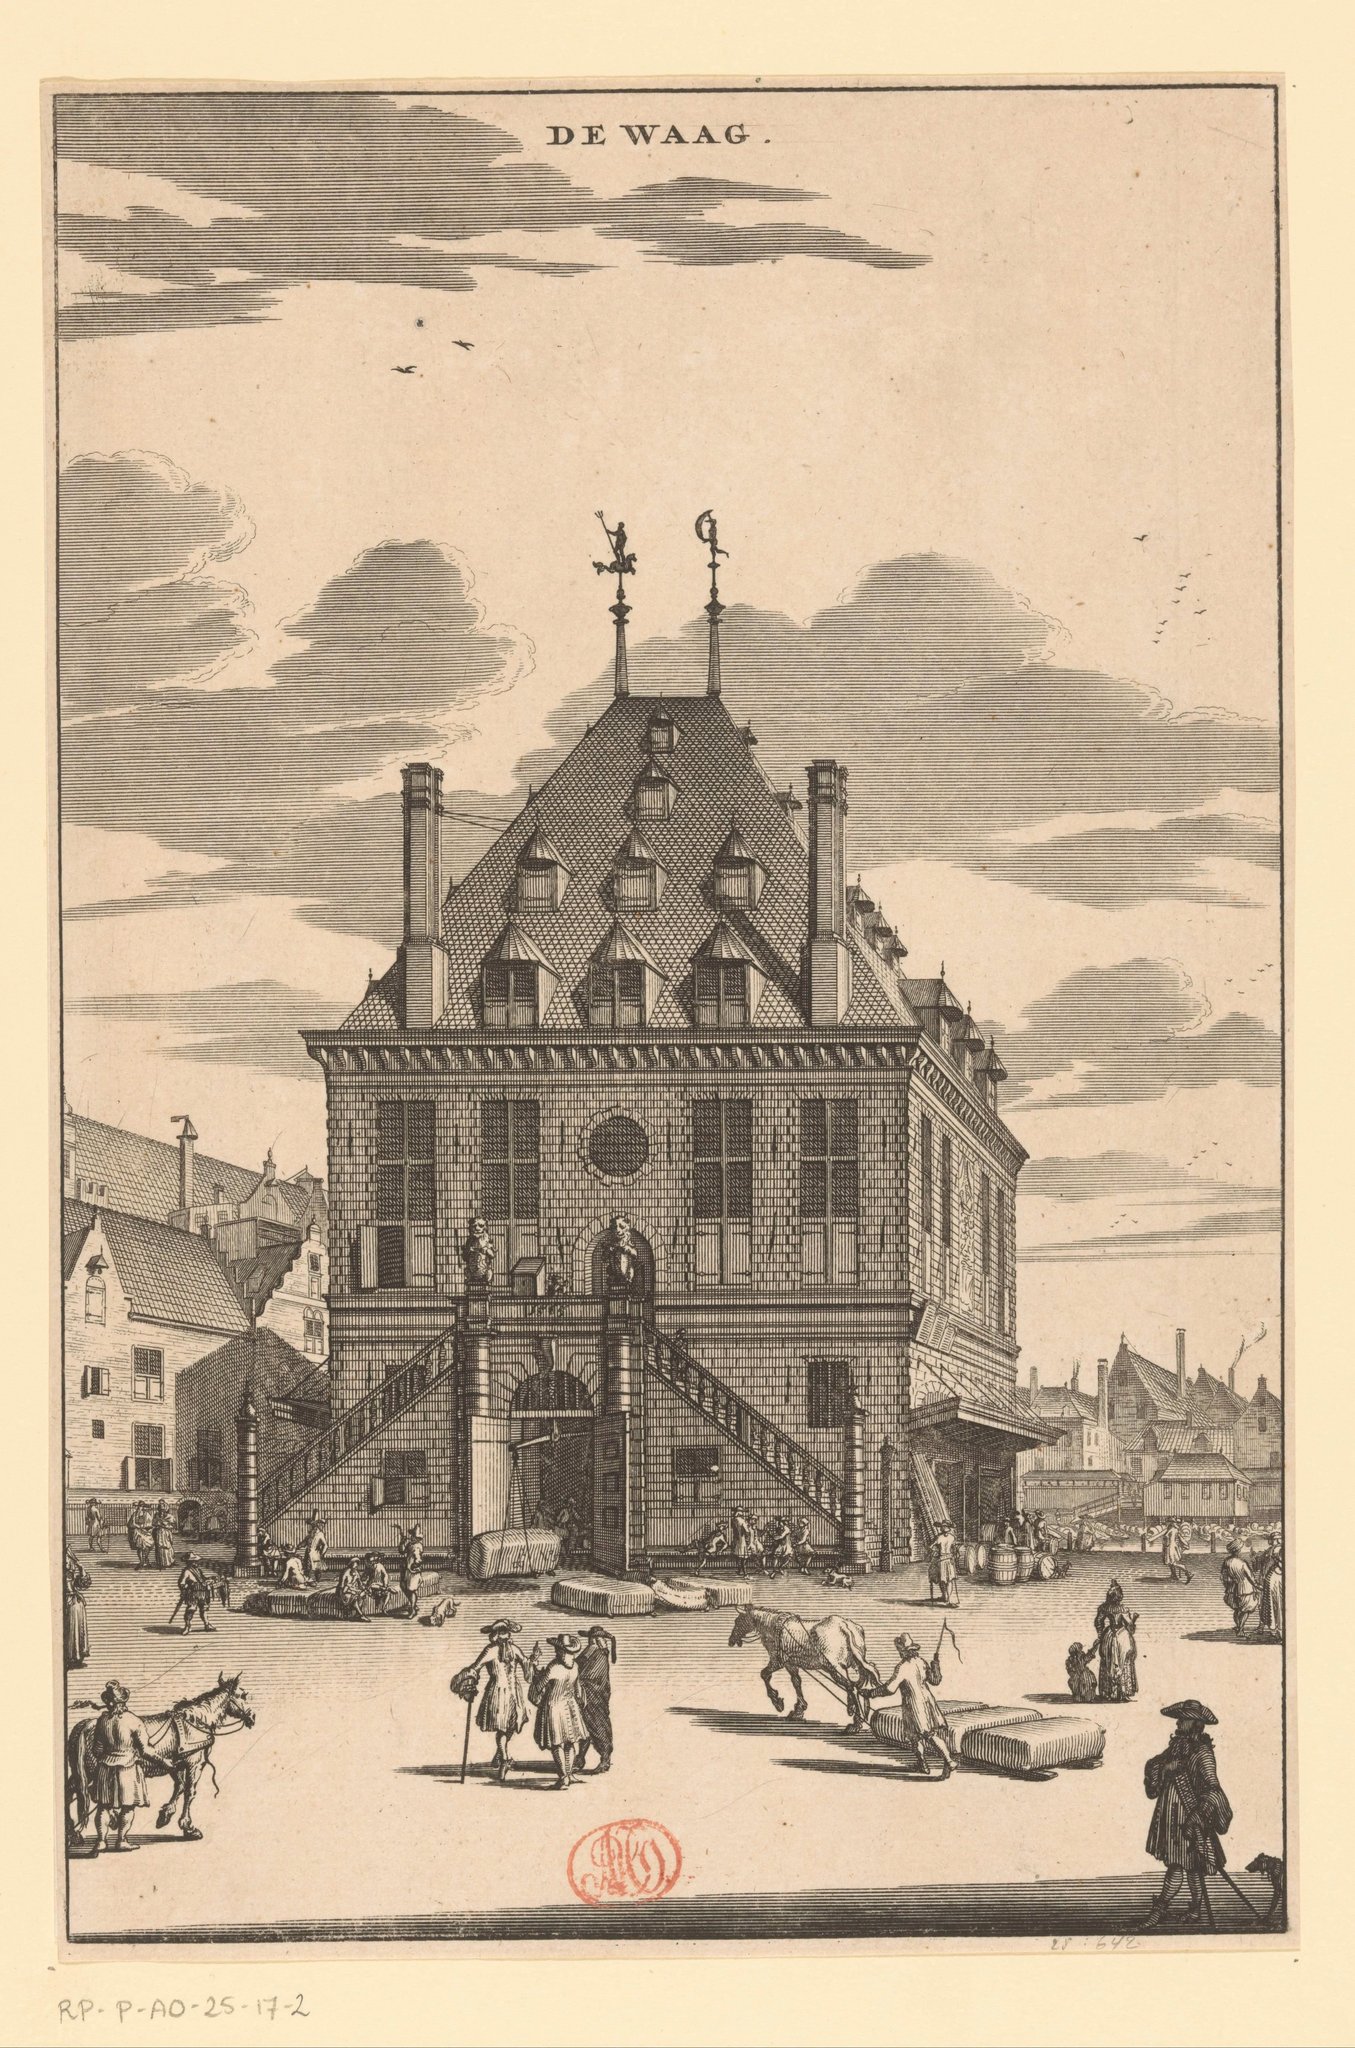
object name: print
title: De Waag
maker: Anonymous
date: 1693-1694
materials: paper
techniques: engraving, etching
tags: weigh-house, square, place, circus, etc. (+ city(-scape) with figures, staffage)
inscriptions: collector's mark: Lugt 195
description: Huidige staat van prent ook gebruikt in: Commelin, Caspar. Beschryvinge van Amsterdam, desselfs eerste oorspronk uyt den Huyse (…). 2 delen. Amsterdam: Abraham Wolfgang, Gillis Janssonius van Waesberge, Johannes Janssonius van Waesberge II, weduwe Dirk Boom I, Hendrick Boom en Rembertus Goethals, 1693. En in: Commelin, Caspar. Beschryvinge van Amsterdam, zynde een naukeurige verhandelinge van desselfs eerste oorspronk uyt (…). 2 delen. Amsterdam: weduwe Aart Dircksz Oossaan, 1694. Latere staat ook gebruikt in: Commelin, Caspar. Beschryvinge van Amsterdam, zynde een naukeurige verhandelinge van desselfs eerste oorspronk uyt (…). 2 delen. 2e druk. Amsterdam: Andries van Damme, Johannes Ratelband, weduwe A. van Aaltwyk en Hermanus Uytwerf, 1726.